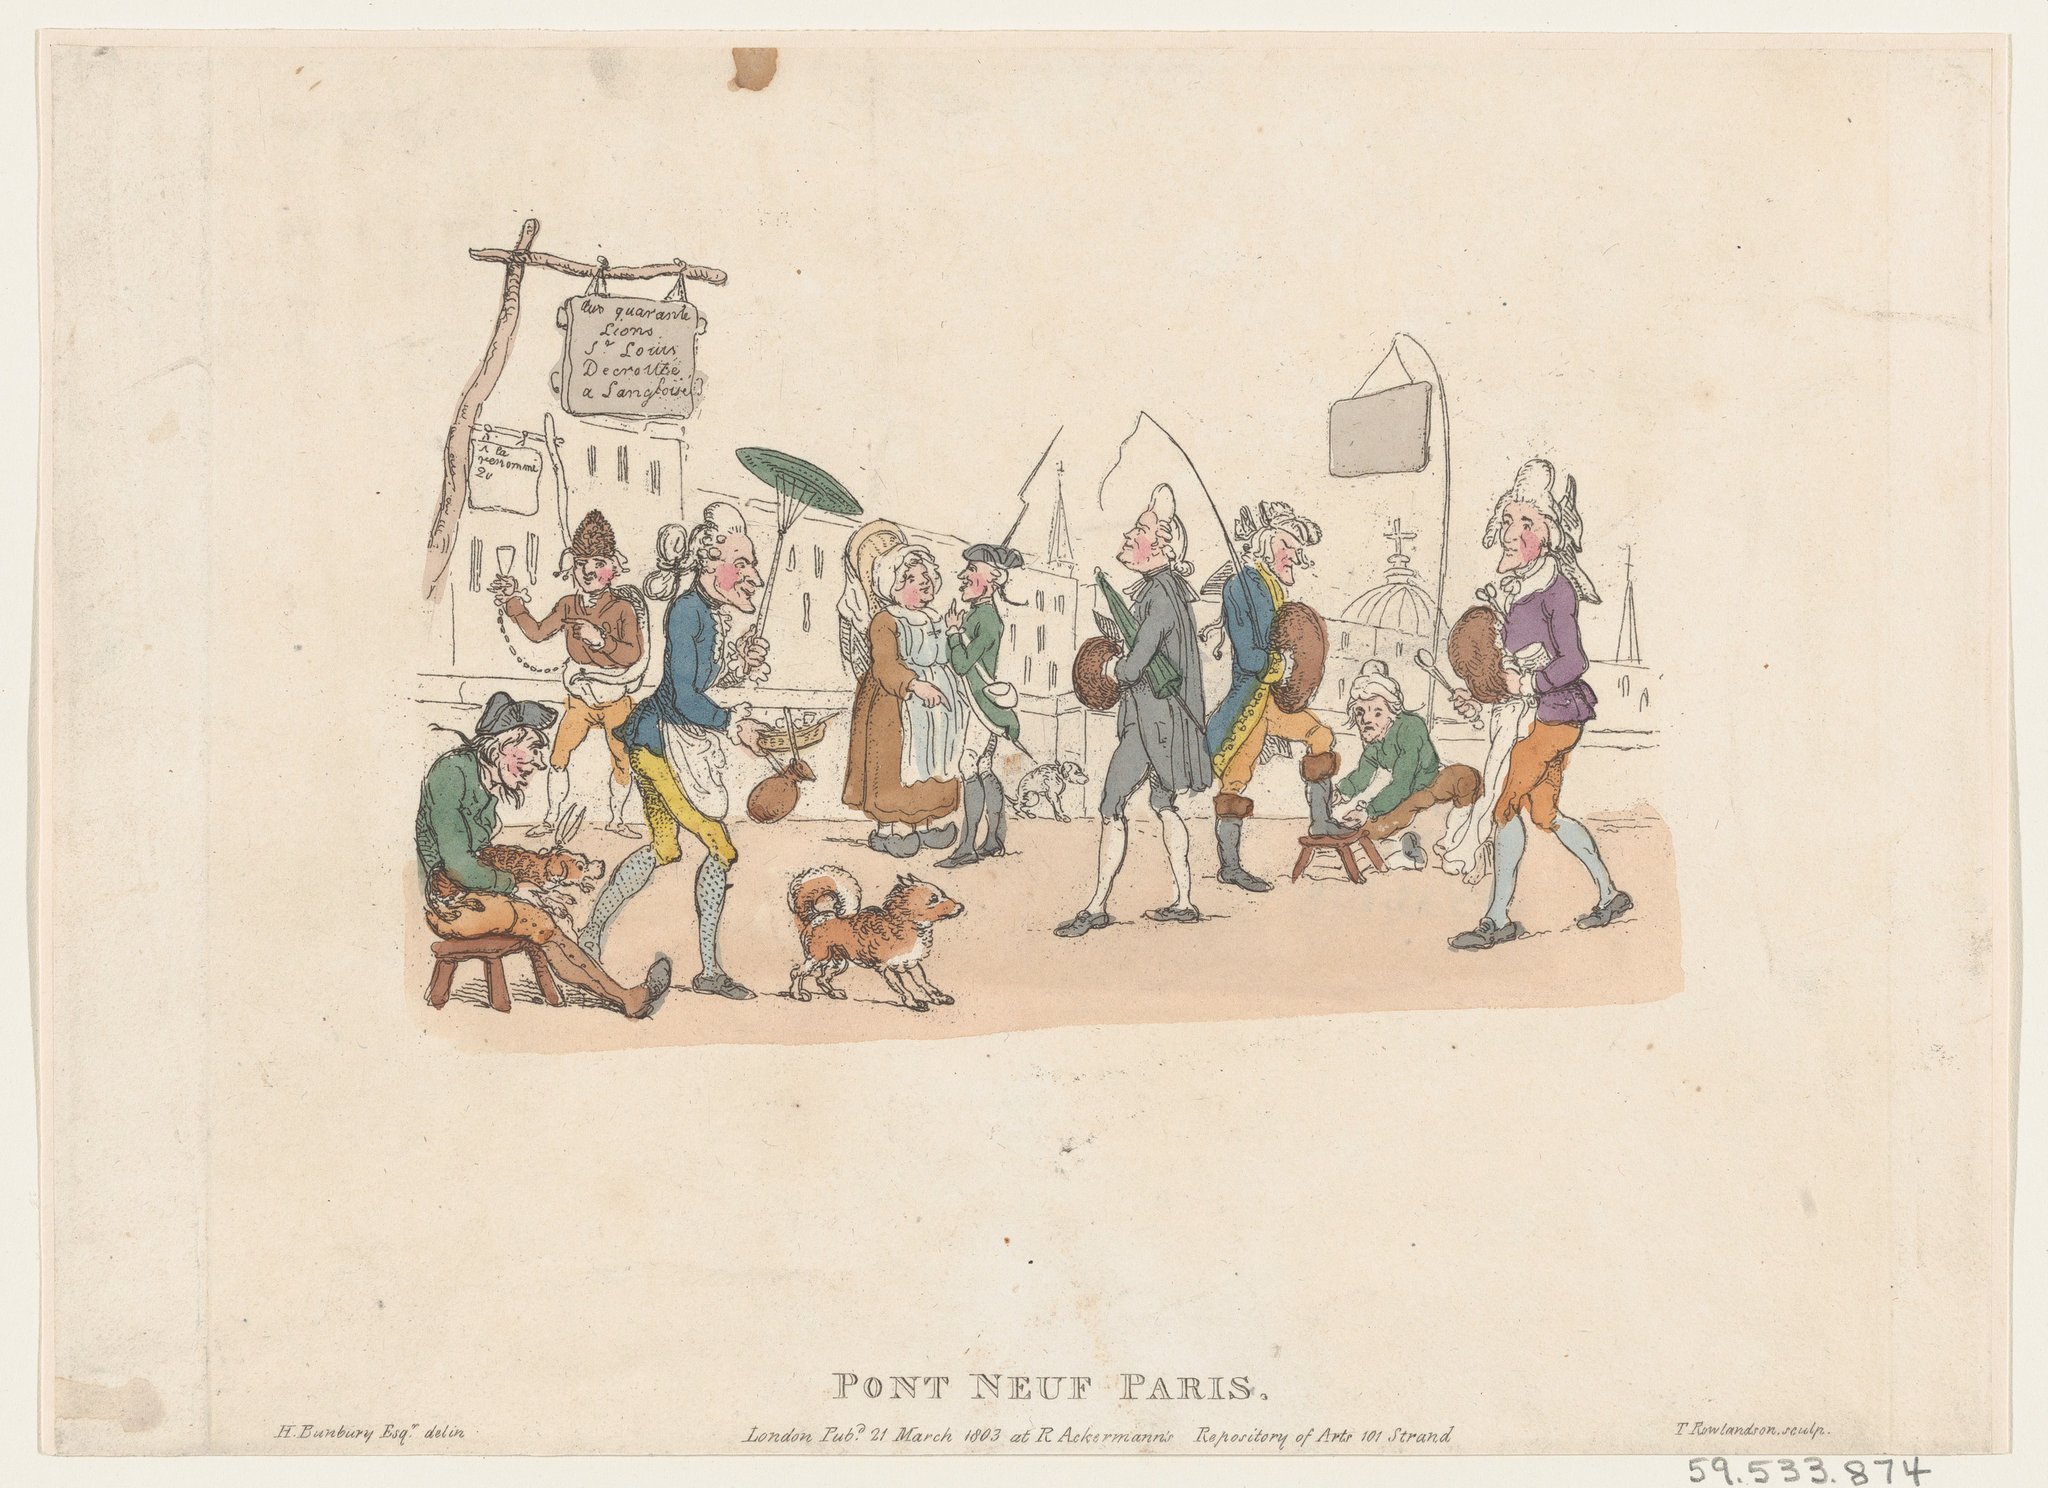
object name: print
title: Pont Neuf, Paris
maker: thomas rowlandson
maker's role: artist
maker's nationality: british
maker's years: 1757-1827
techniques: etching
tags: satire,men,women,dogs